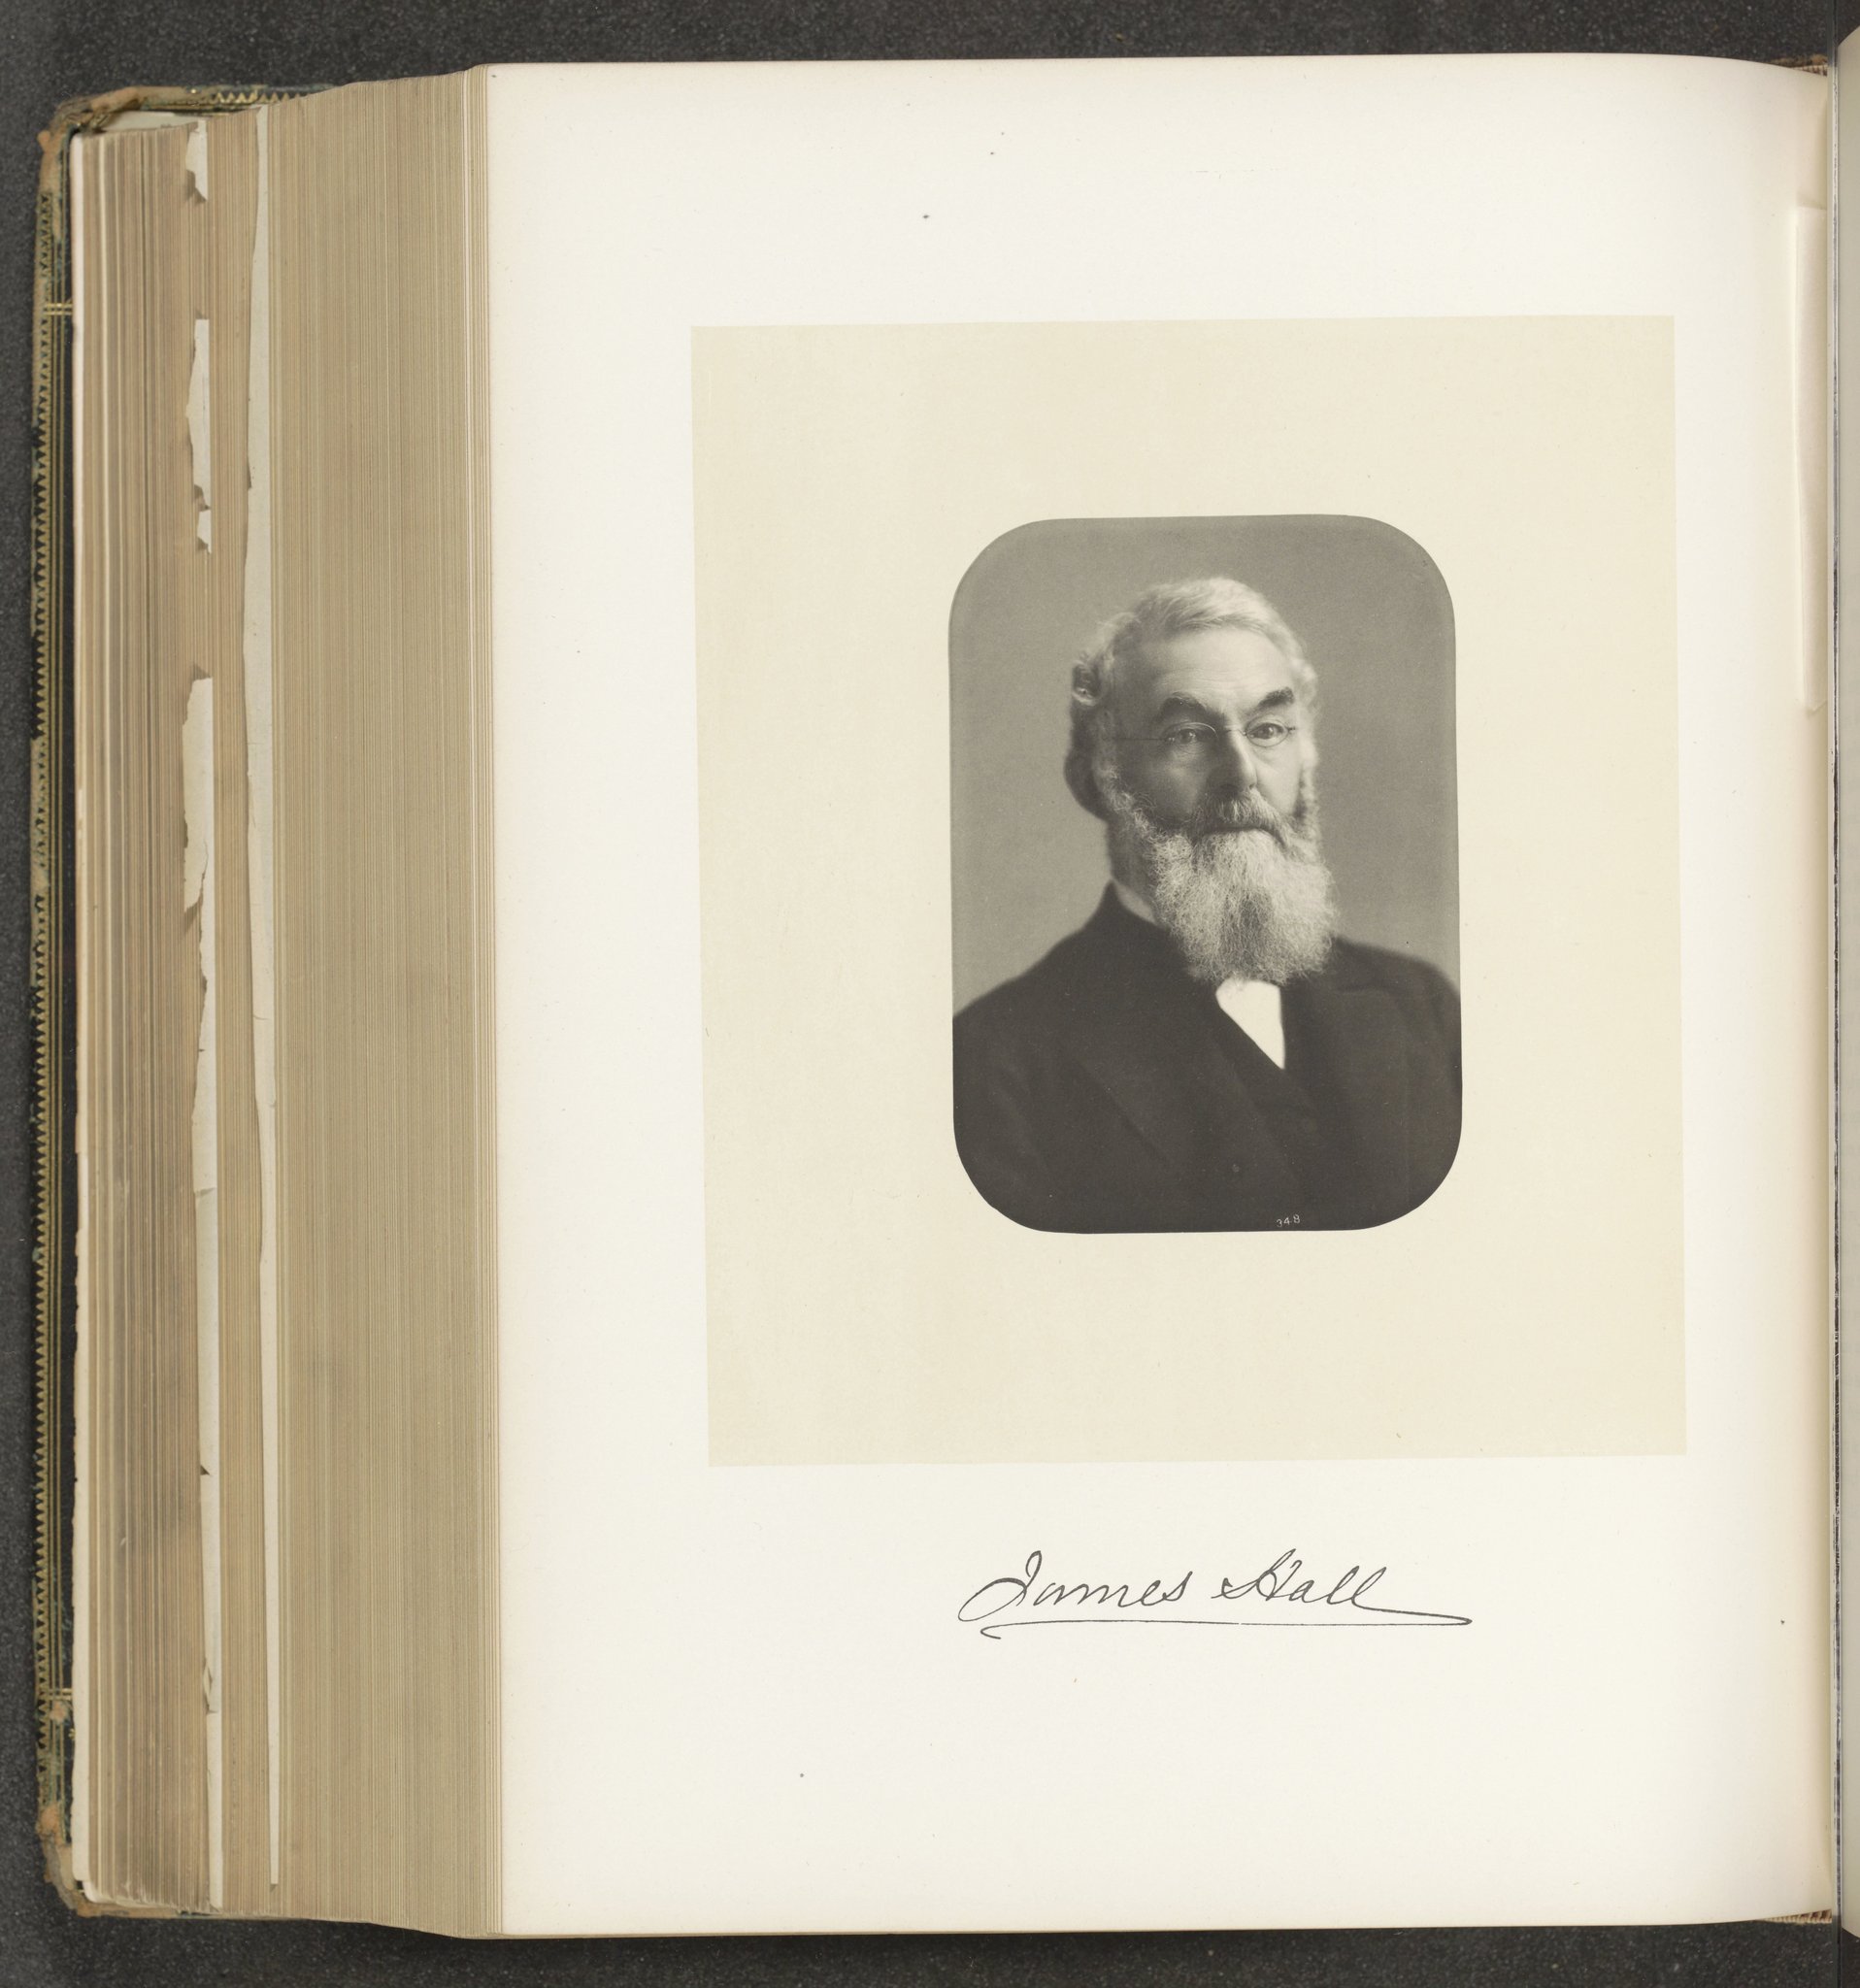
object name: photomechanical print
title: Portret van James Hall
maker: Anonymous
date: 1872-1882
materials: paper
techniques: photograph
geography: united states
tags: historical persons (portraits and scenes from the life) (+ head (and shoulders) (portrait))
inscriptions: annotation, number: ‘348’